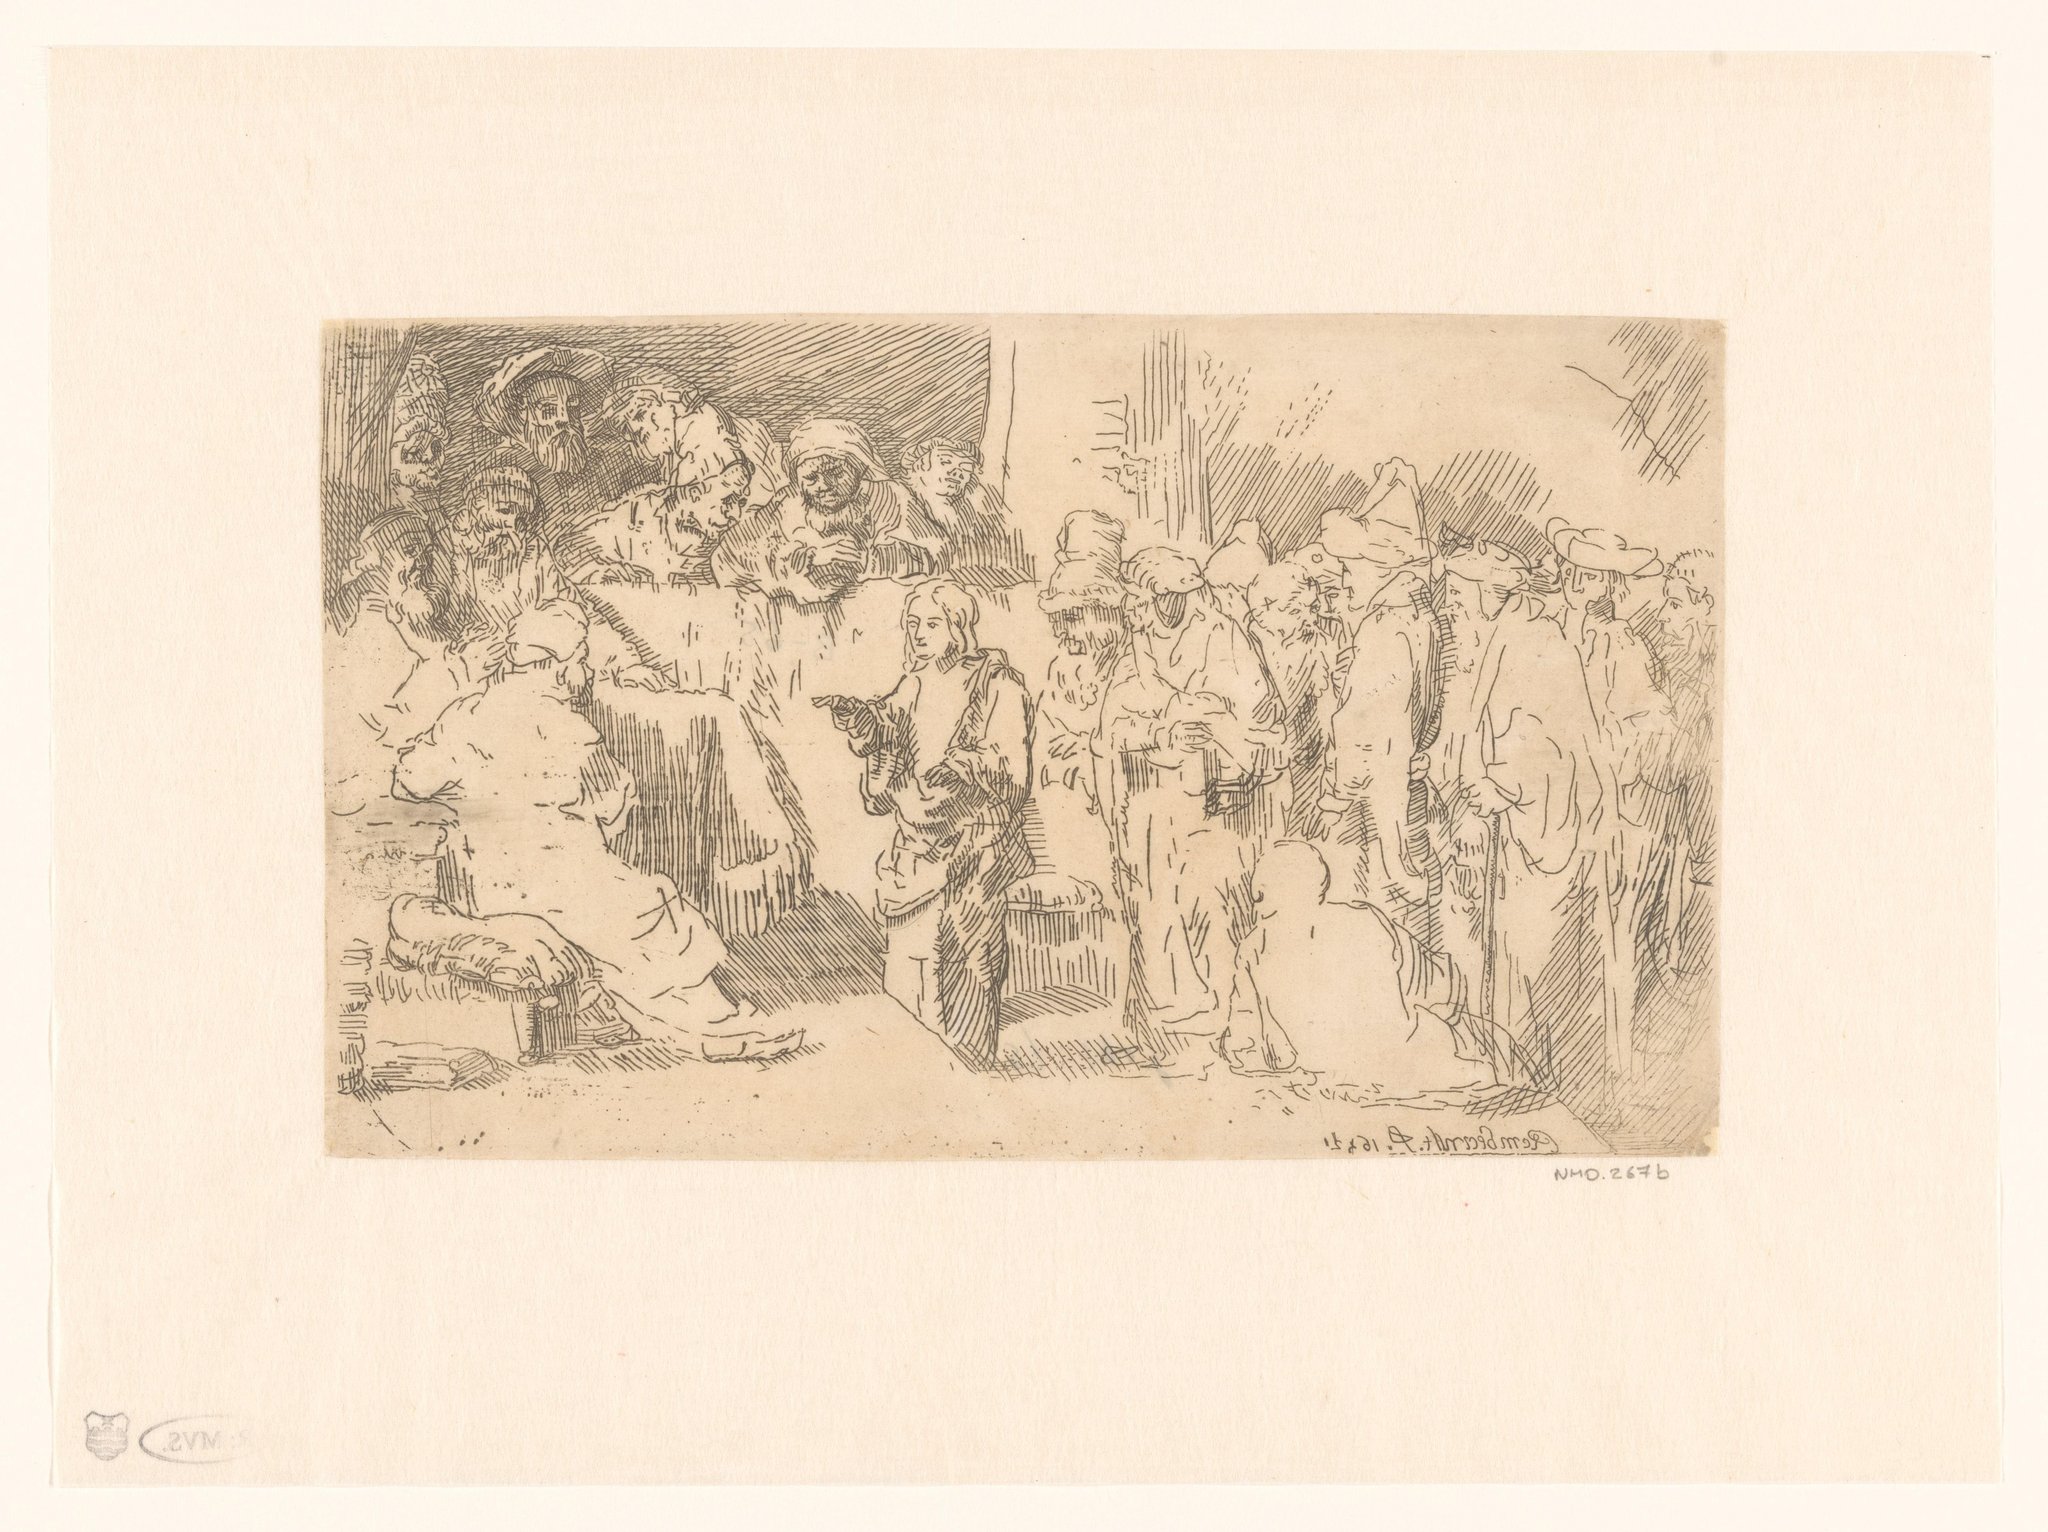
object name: print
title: Christ disputing with the doctors: a sketch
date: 1757-1825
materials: paper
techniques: etching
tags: christ explaining his doctrine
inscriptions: collector's mark: Lugt 2228, collector's mark: Lugt 2760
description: Spiegelbeeldige kopie naar de gelijknamige prent van Rembrandt.